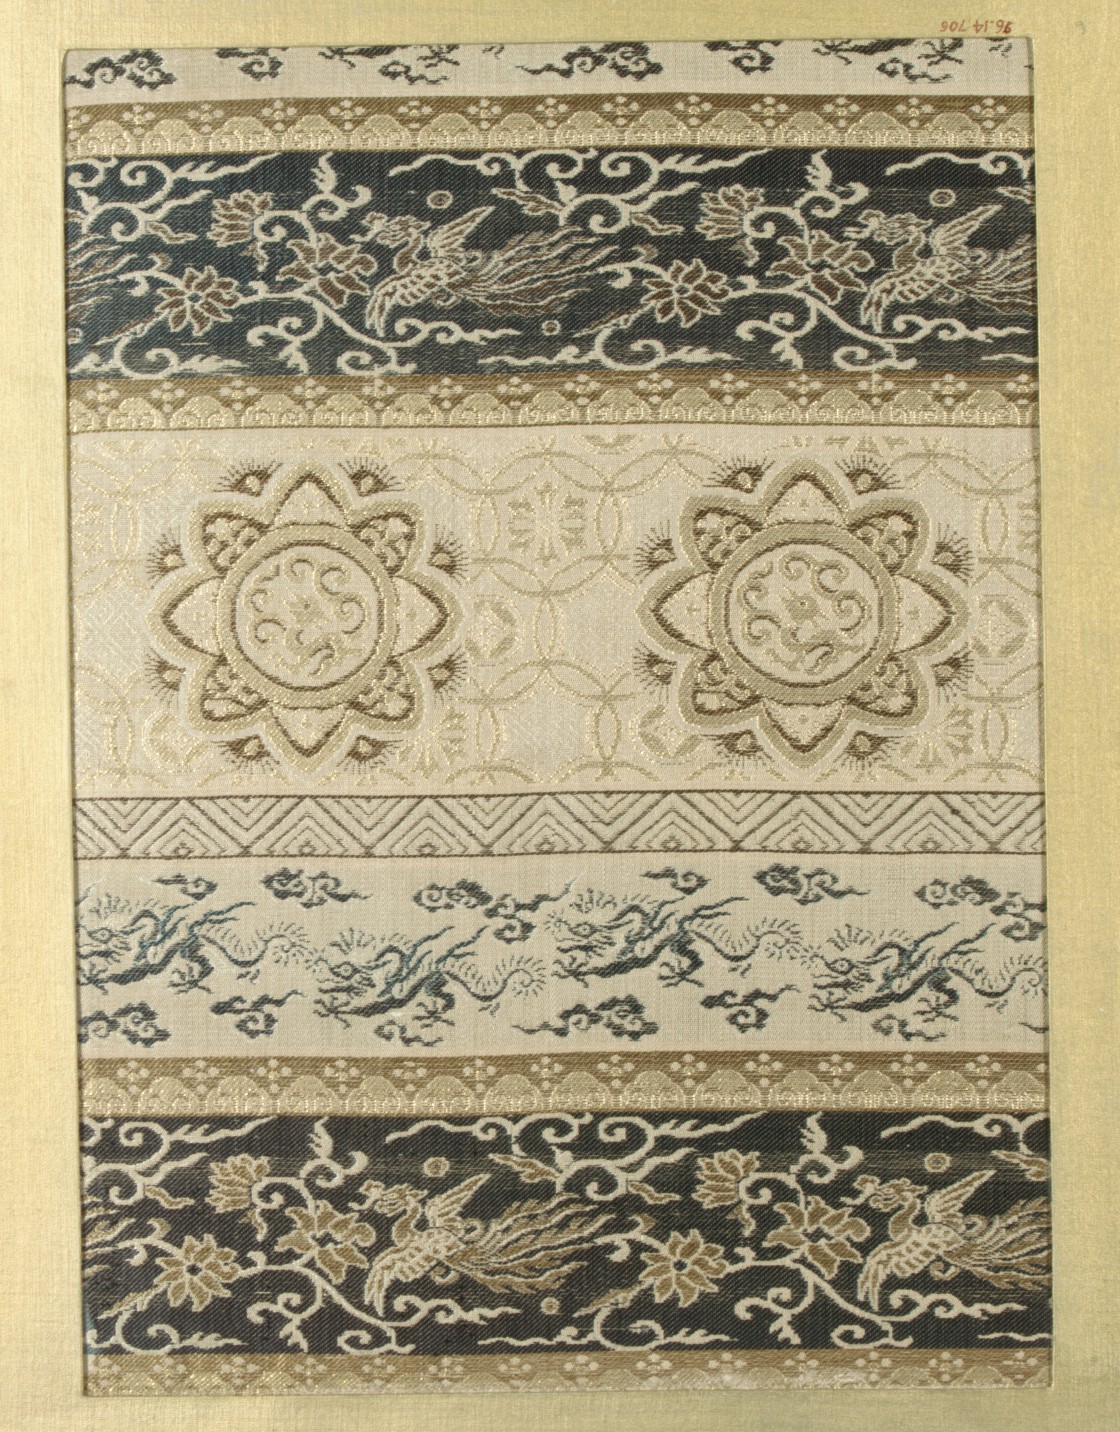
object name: piece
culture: japanese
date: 1701-1900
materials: silk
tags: birds